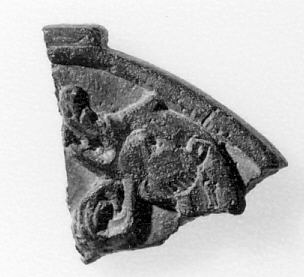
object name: box lid fragment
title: Fragment of a Box Lid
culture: gandhara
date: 401-500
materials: stone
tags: gandhara